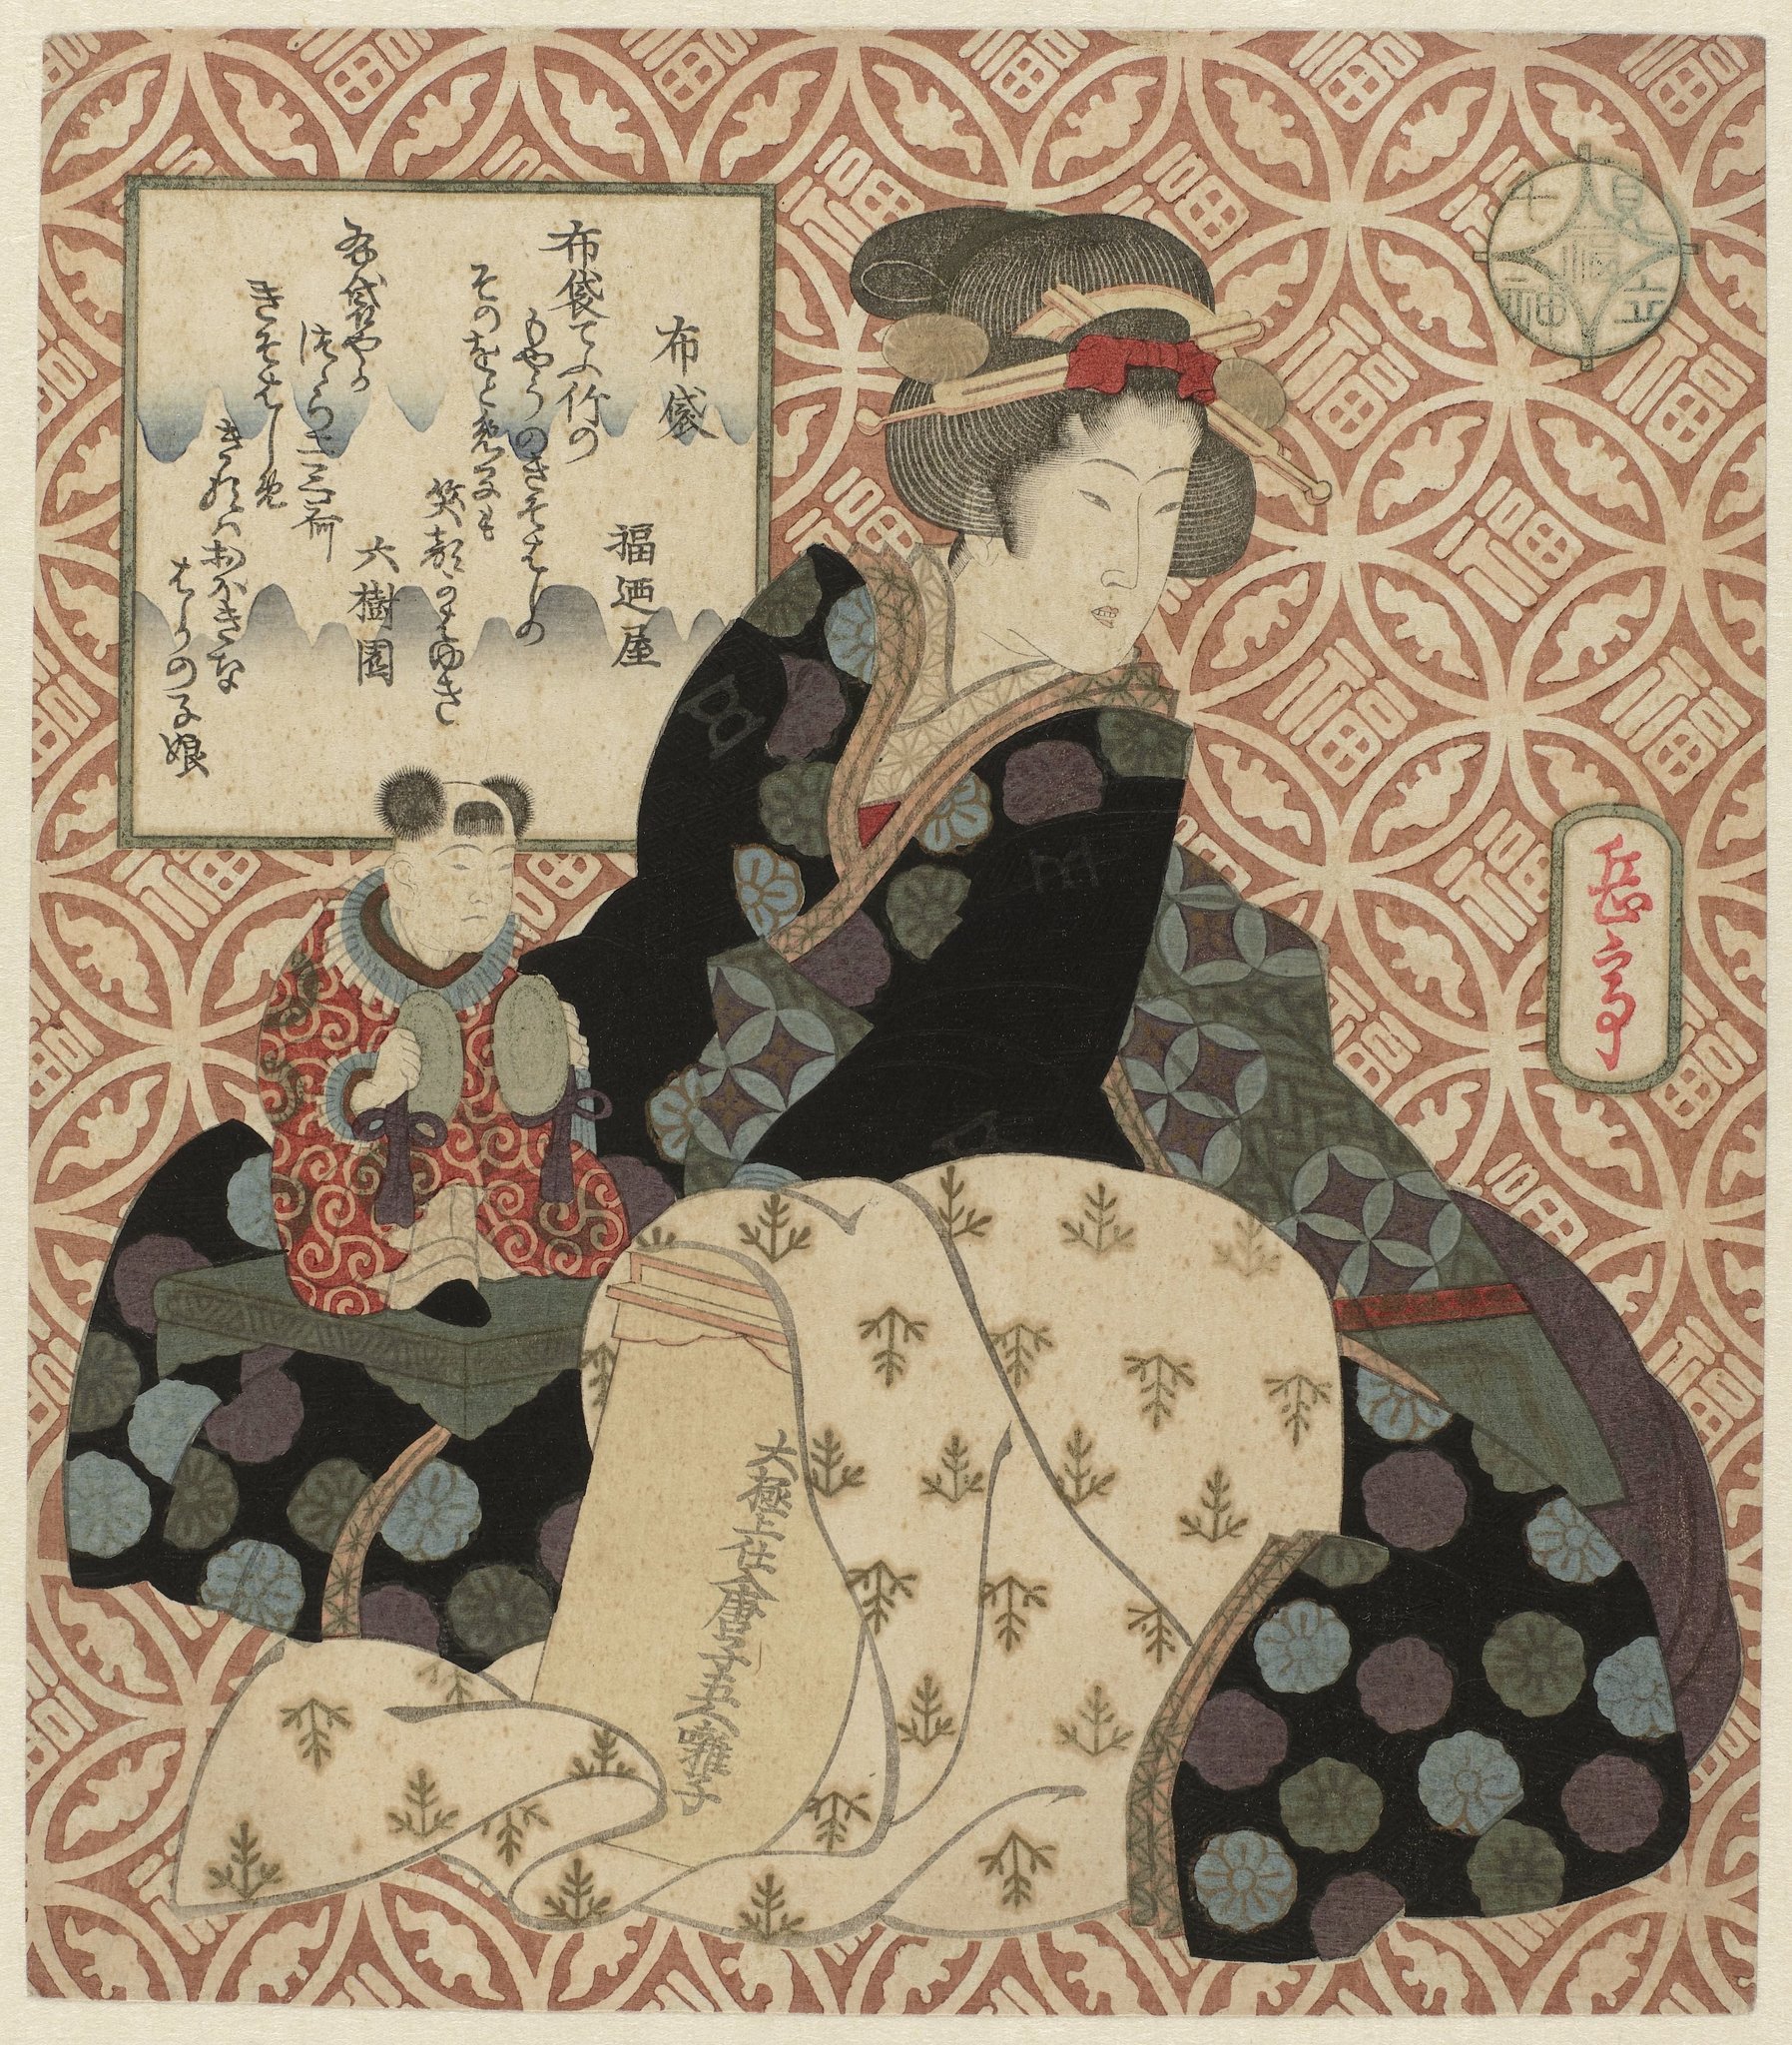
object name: print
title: Mitate shichifukujin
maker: yashima gakutei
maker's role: print maker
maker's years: 1786-1868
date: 1868-1912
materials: paper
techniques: woodcut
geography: japan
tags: dolls for adults, courtesan, hetaera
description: Een surimono is een luxe uitgevoerde prent waarop beeld met één of meerdere gedichten gecombineerd is. Bij het drukken van een surimono werd vaak gebruik gemaakt van dikker papier, blinddruk en metaal pigmenten, zoals koper- en zilverpoeder. De prenten werden vaak in opdracht van dichters gemaakt en als exclusief geschenk aan vrienden en relaties gegeven.